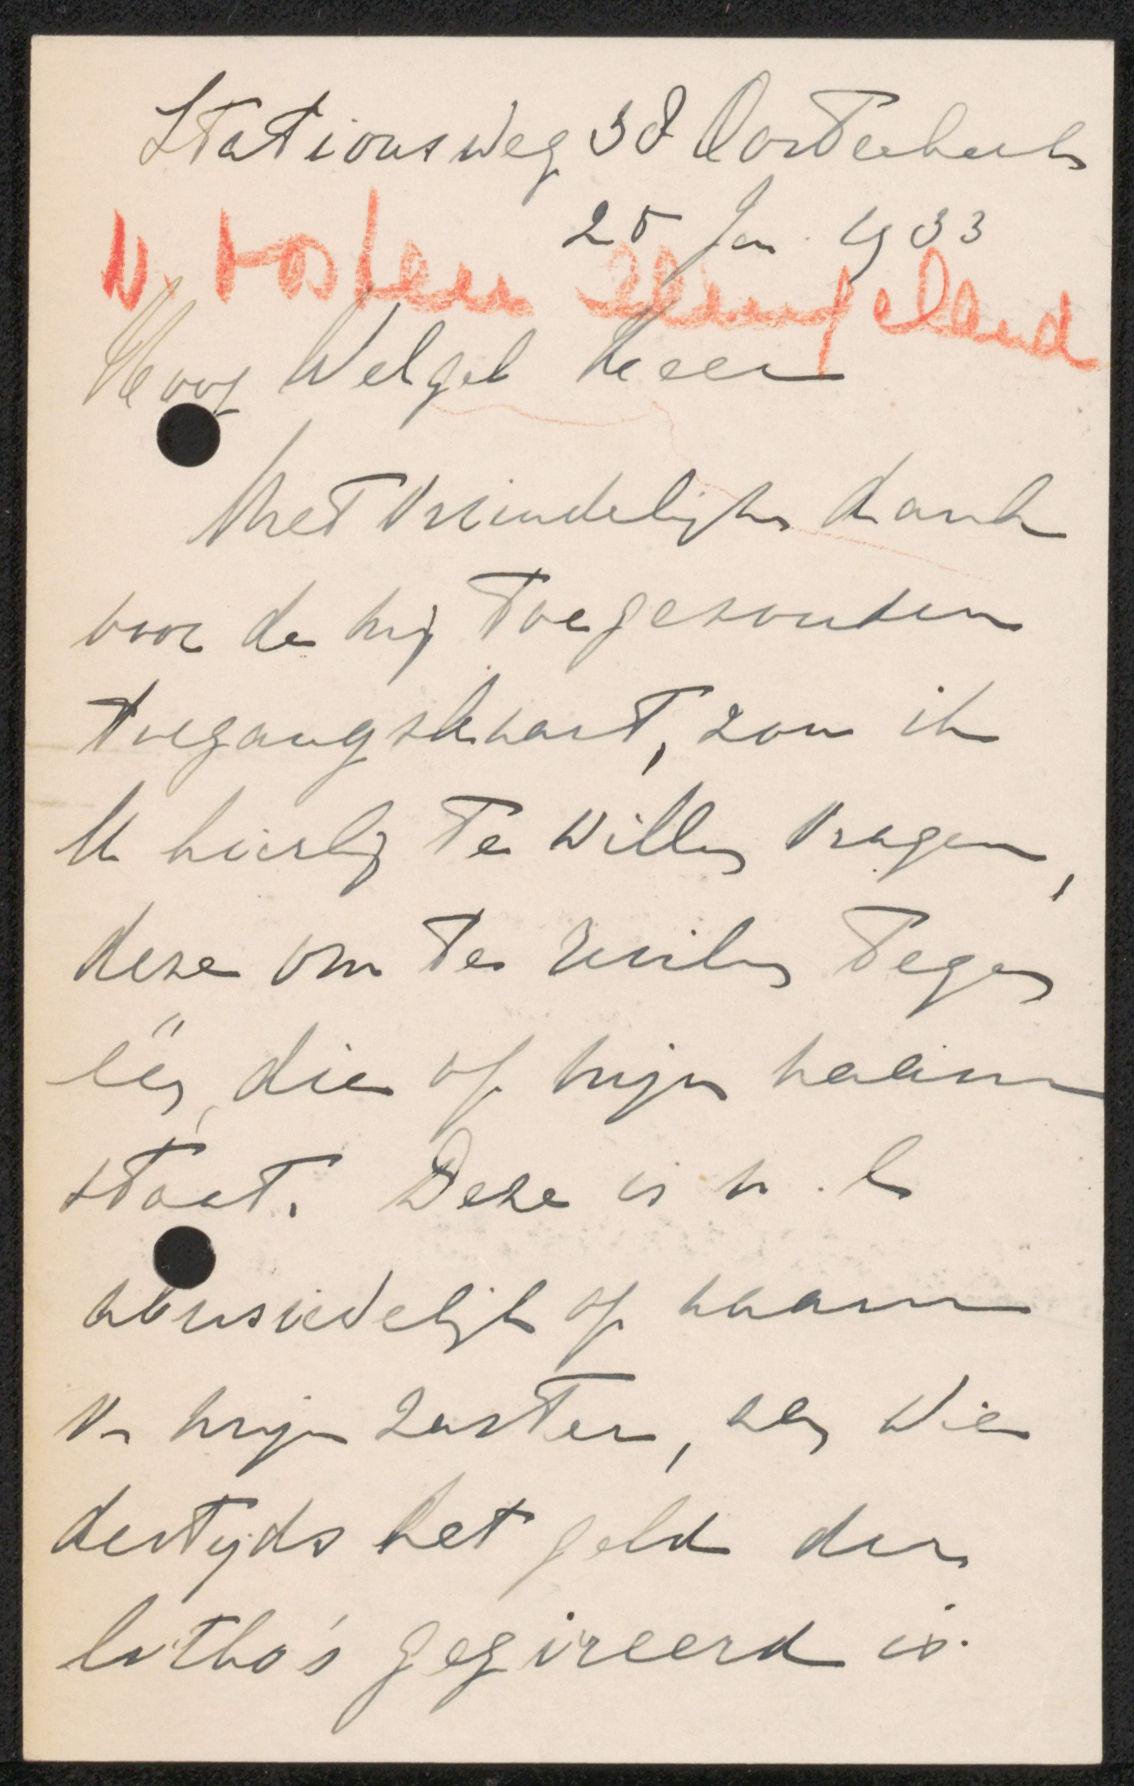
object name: letter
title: Brief aan jonkheer Hendrik Teding van Berkhout (1879-1969)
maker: jo van oosten slingeland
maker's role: draughtsman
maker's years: 1877-1945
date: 1933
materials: cardboard, ink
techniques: pen, writing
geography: oosterbeek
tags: print room, print maker, c.j.g. cool-van oosten slingeland, haarlem, amsterdam, jonkheer hendrik teding van berkhout (1879-1969)